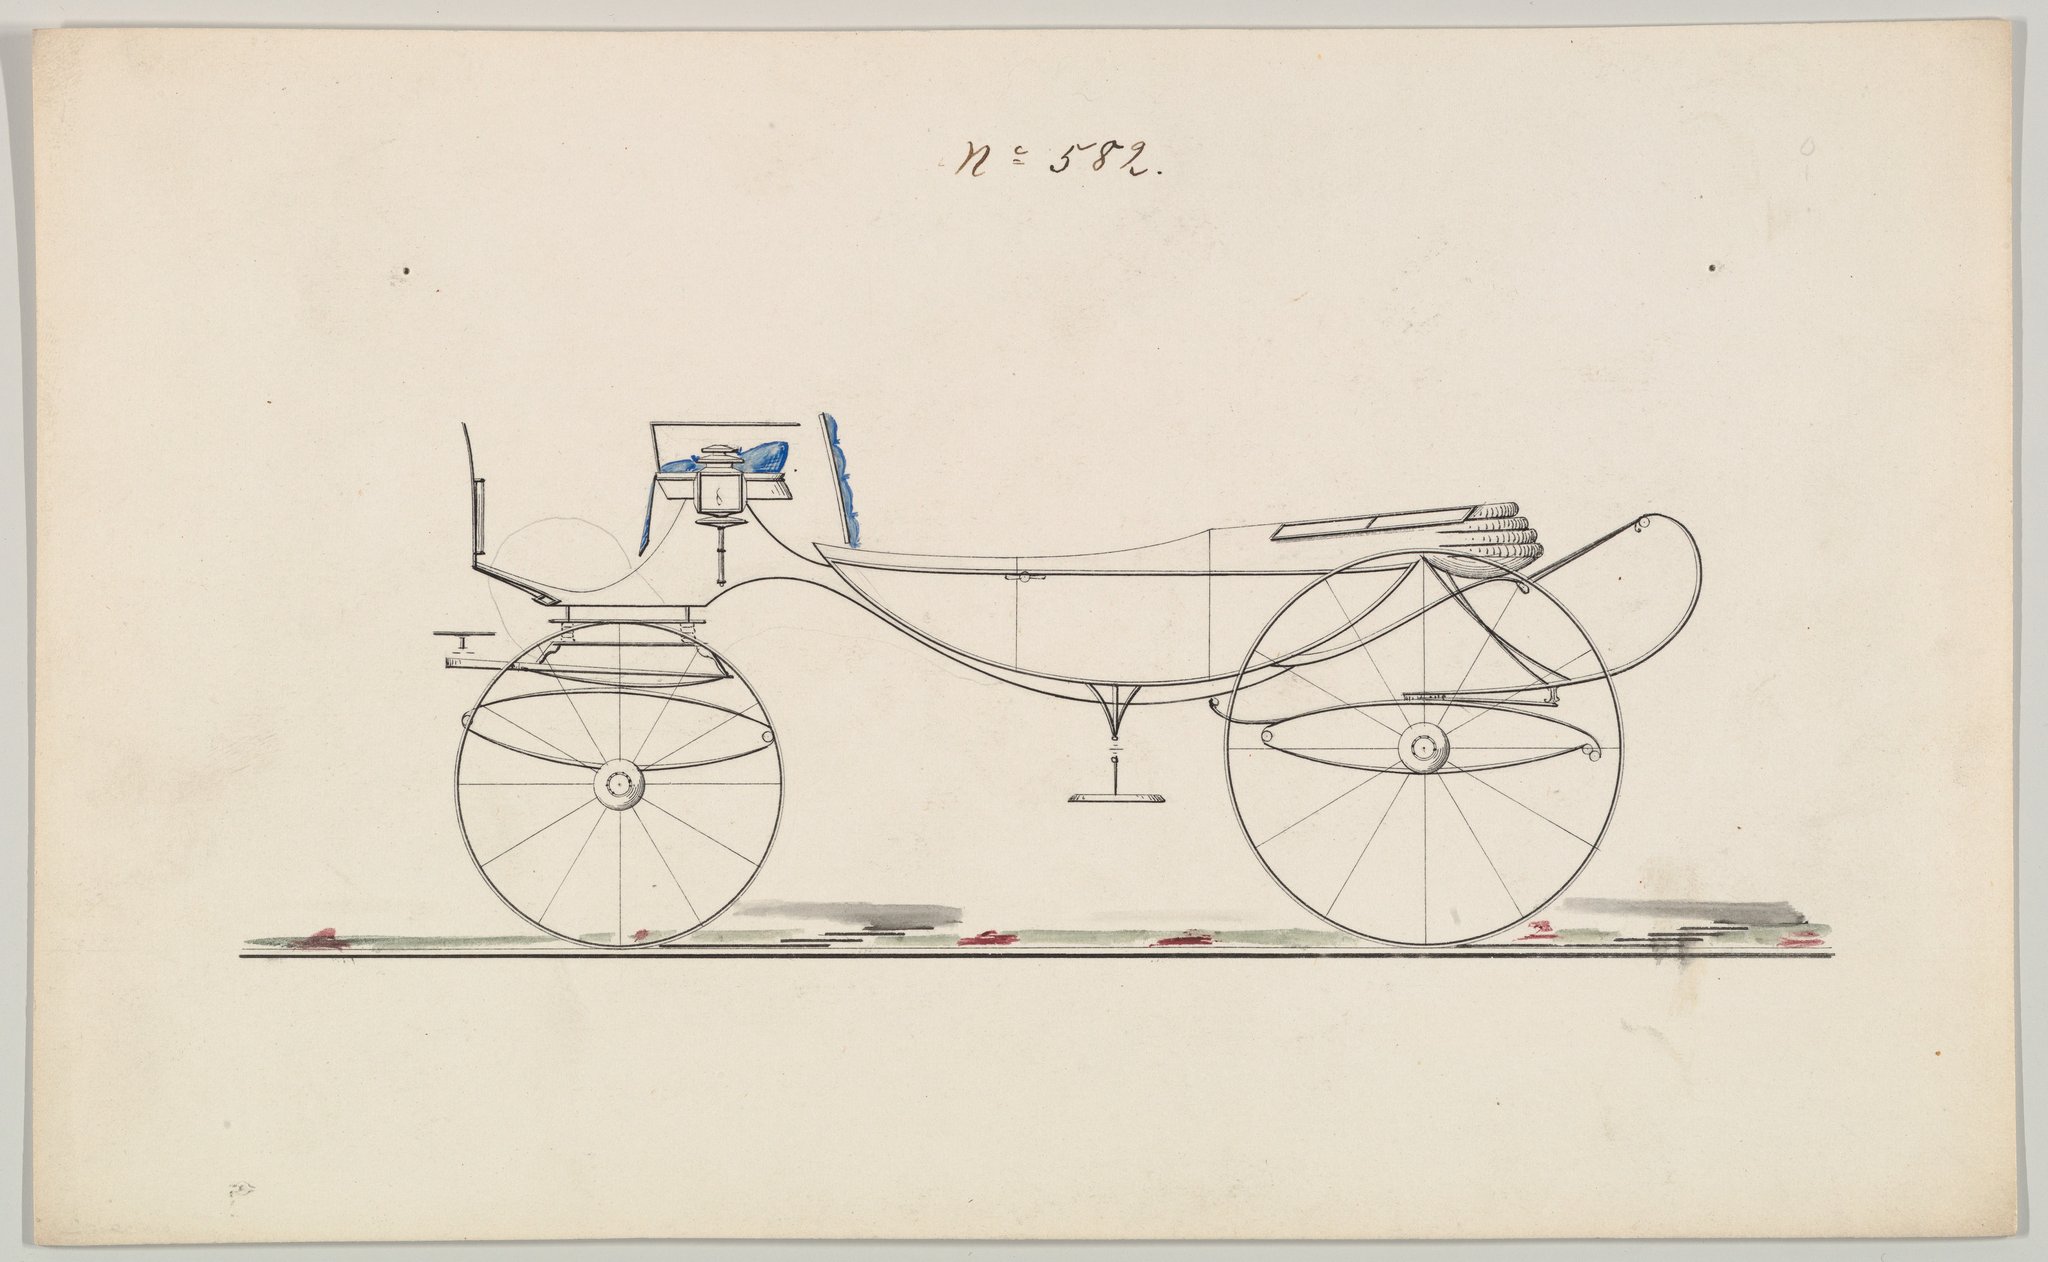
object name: drawing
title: Design for Vis-à-vis/ Caleche, no. 582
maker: brewster & co.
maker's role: manufacturer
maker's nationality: american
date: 1850-1870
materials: ink, watercolor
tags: carriages